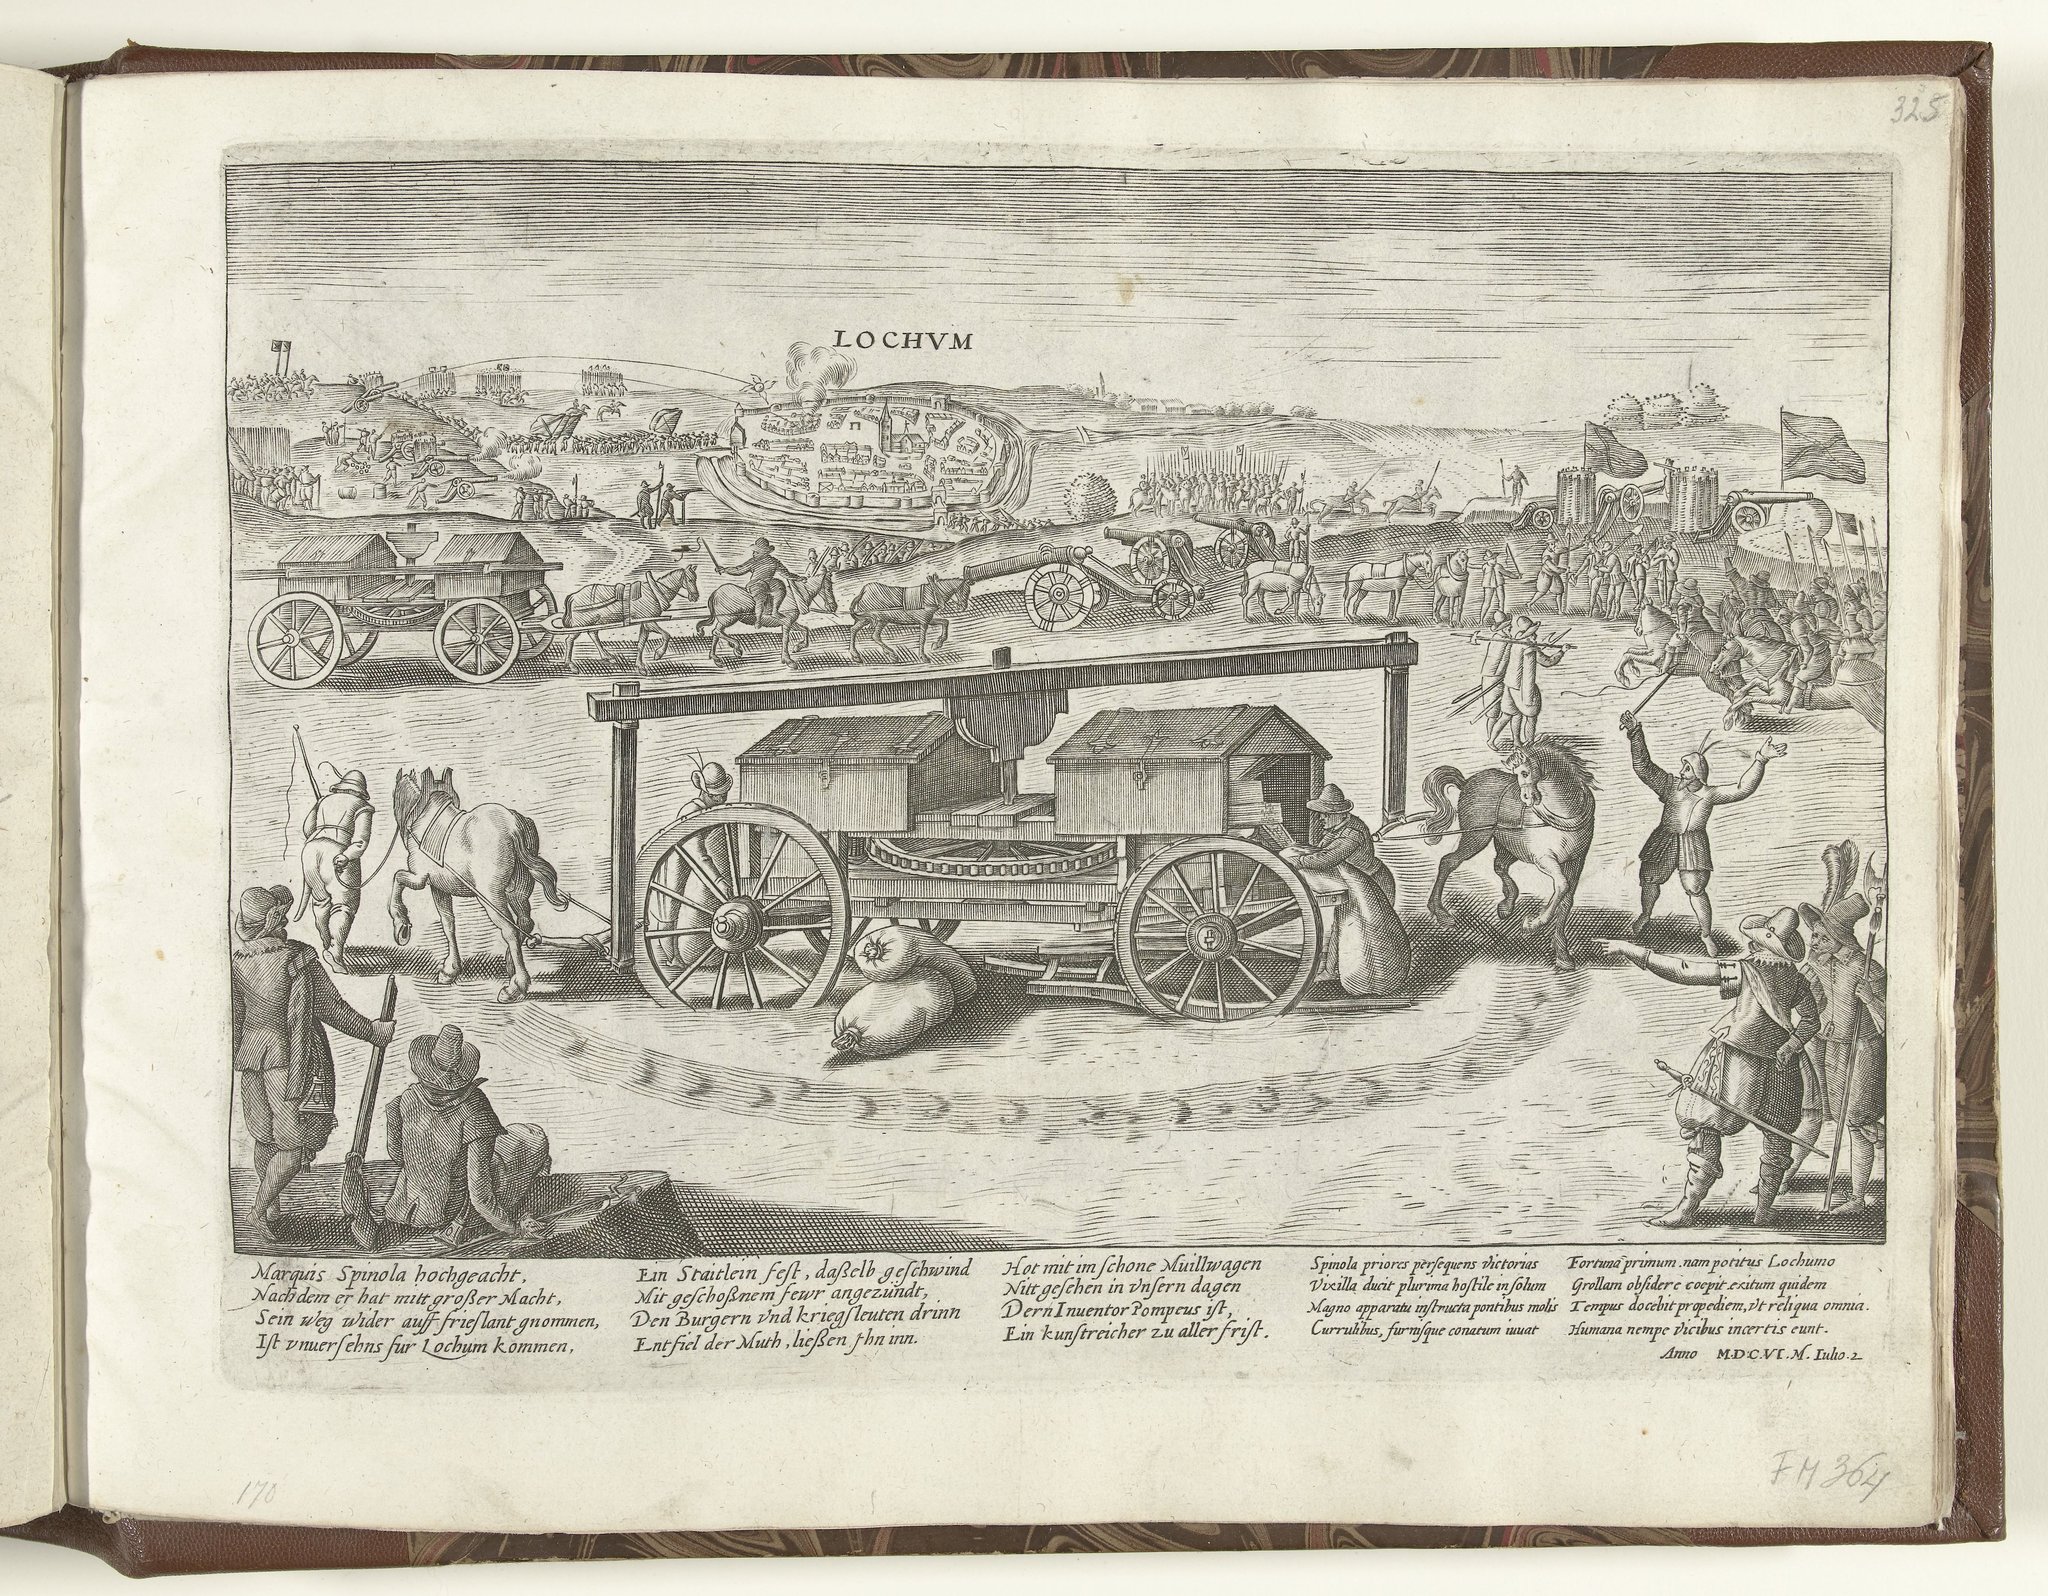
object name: print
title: Serie 10: Nederlandse en Buitenlandse Gebeurtenissen, 1587-1612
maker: frans hogenberg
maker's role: print maker, publisher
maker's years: 1538-1590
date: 1606-1608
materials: paper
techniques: engraving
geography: cologne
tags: pompeo targone, capture of city (after the siege), grinding, milling (industrial processes)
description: Inname van Lochem door het leger van Spinola, 23 juli 1606. Op de voorgrond een meelwagen uitgevonden door Pompeo Targone waarmee in het Spaanse legerkamp graan gemalen kon worden. Met onderschrift van 12 regels in het Duits en 8 regels in het Latijn. Ongenummerd.